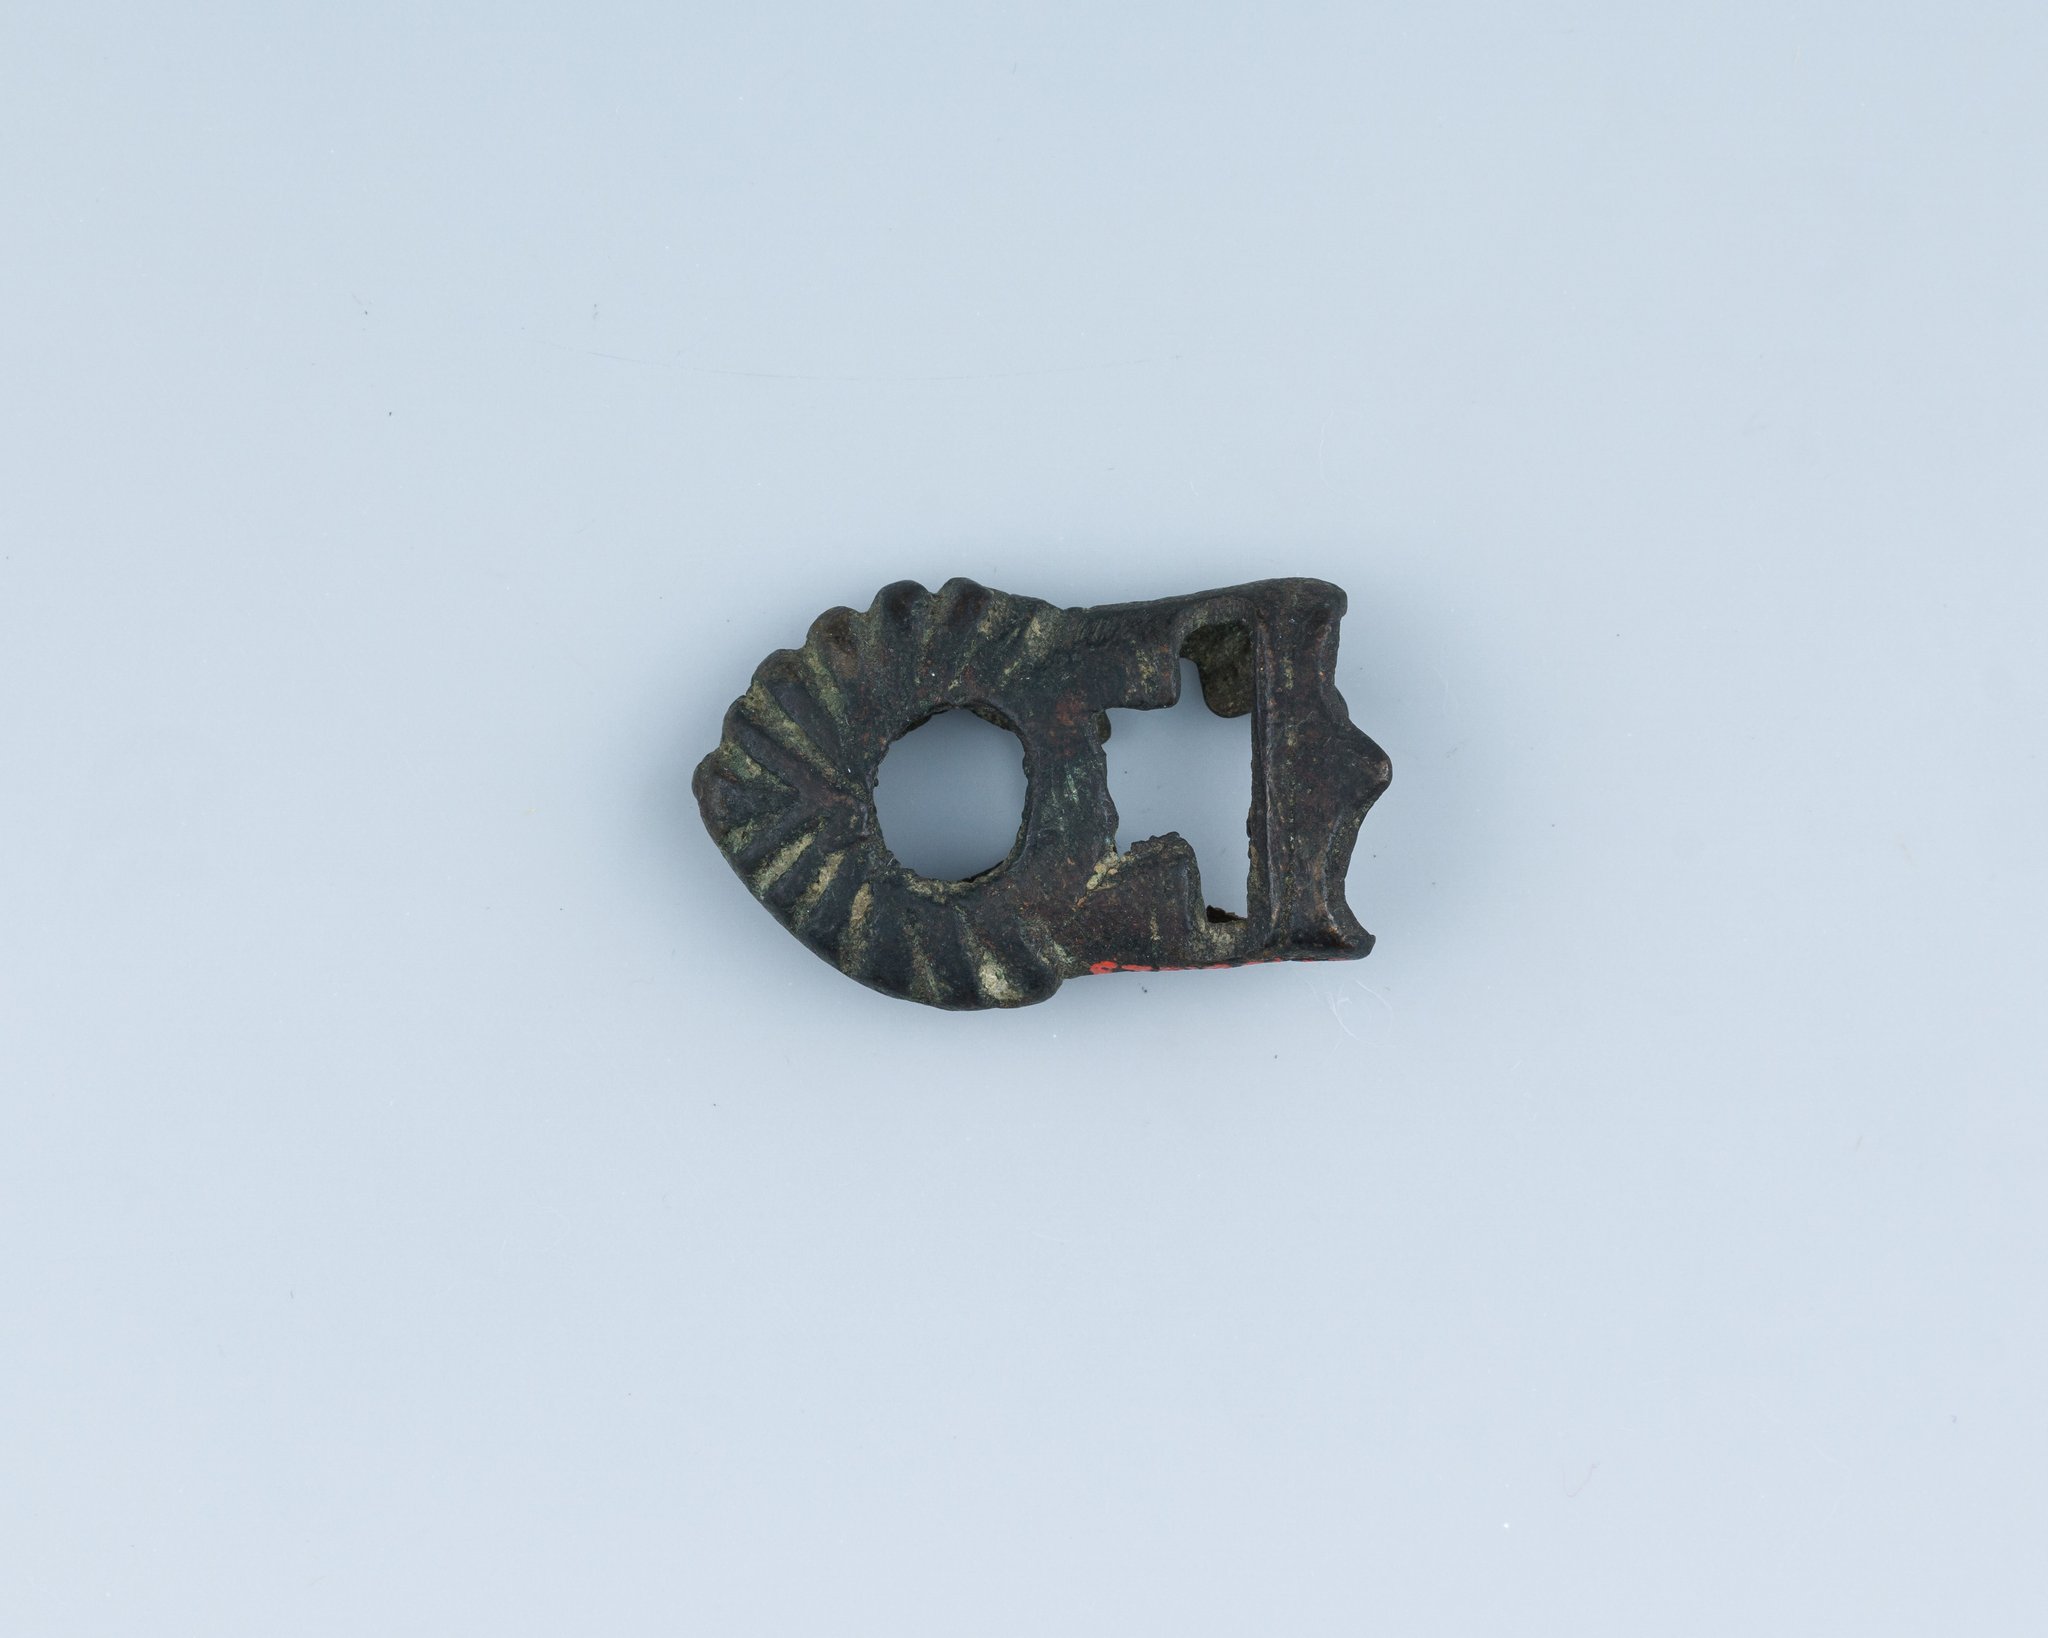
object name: mordant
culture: european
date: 1401-1700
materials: bronze